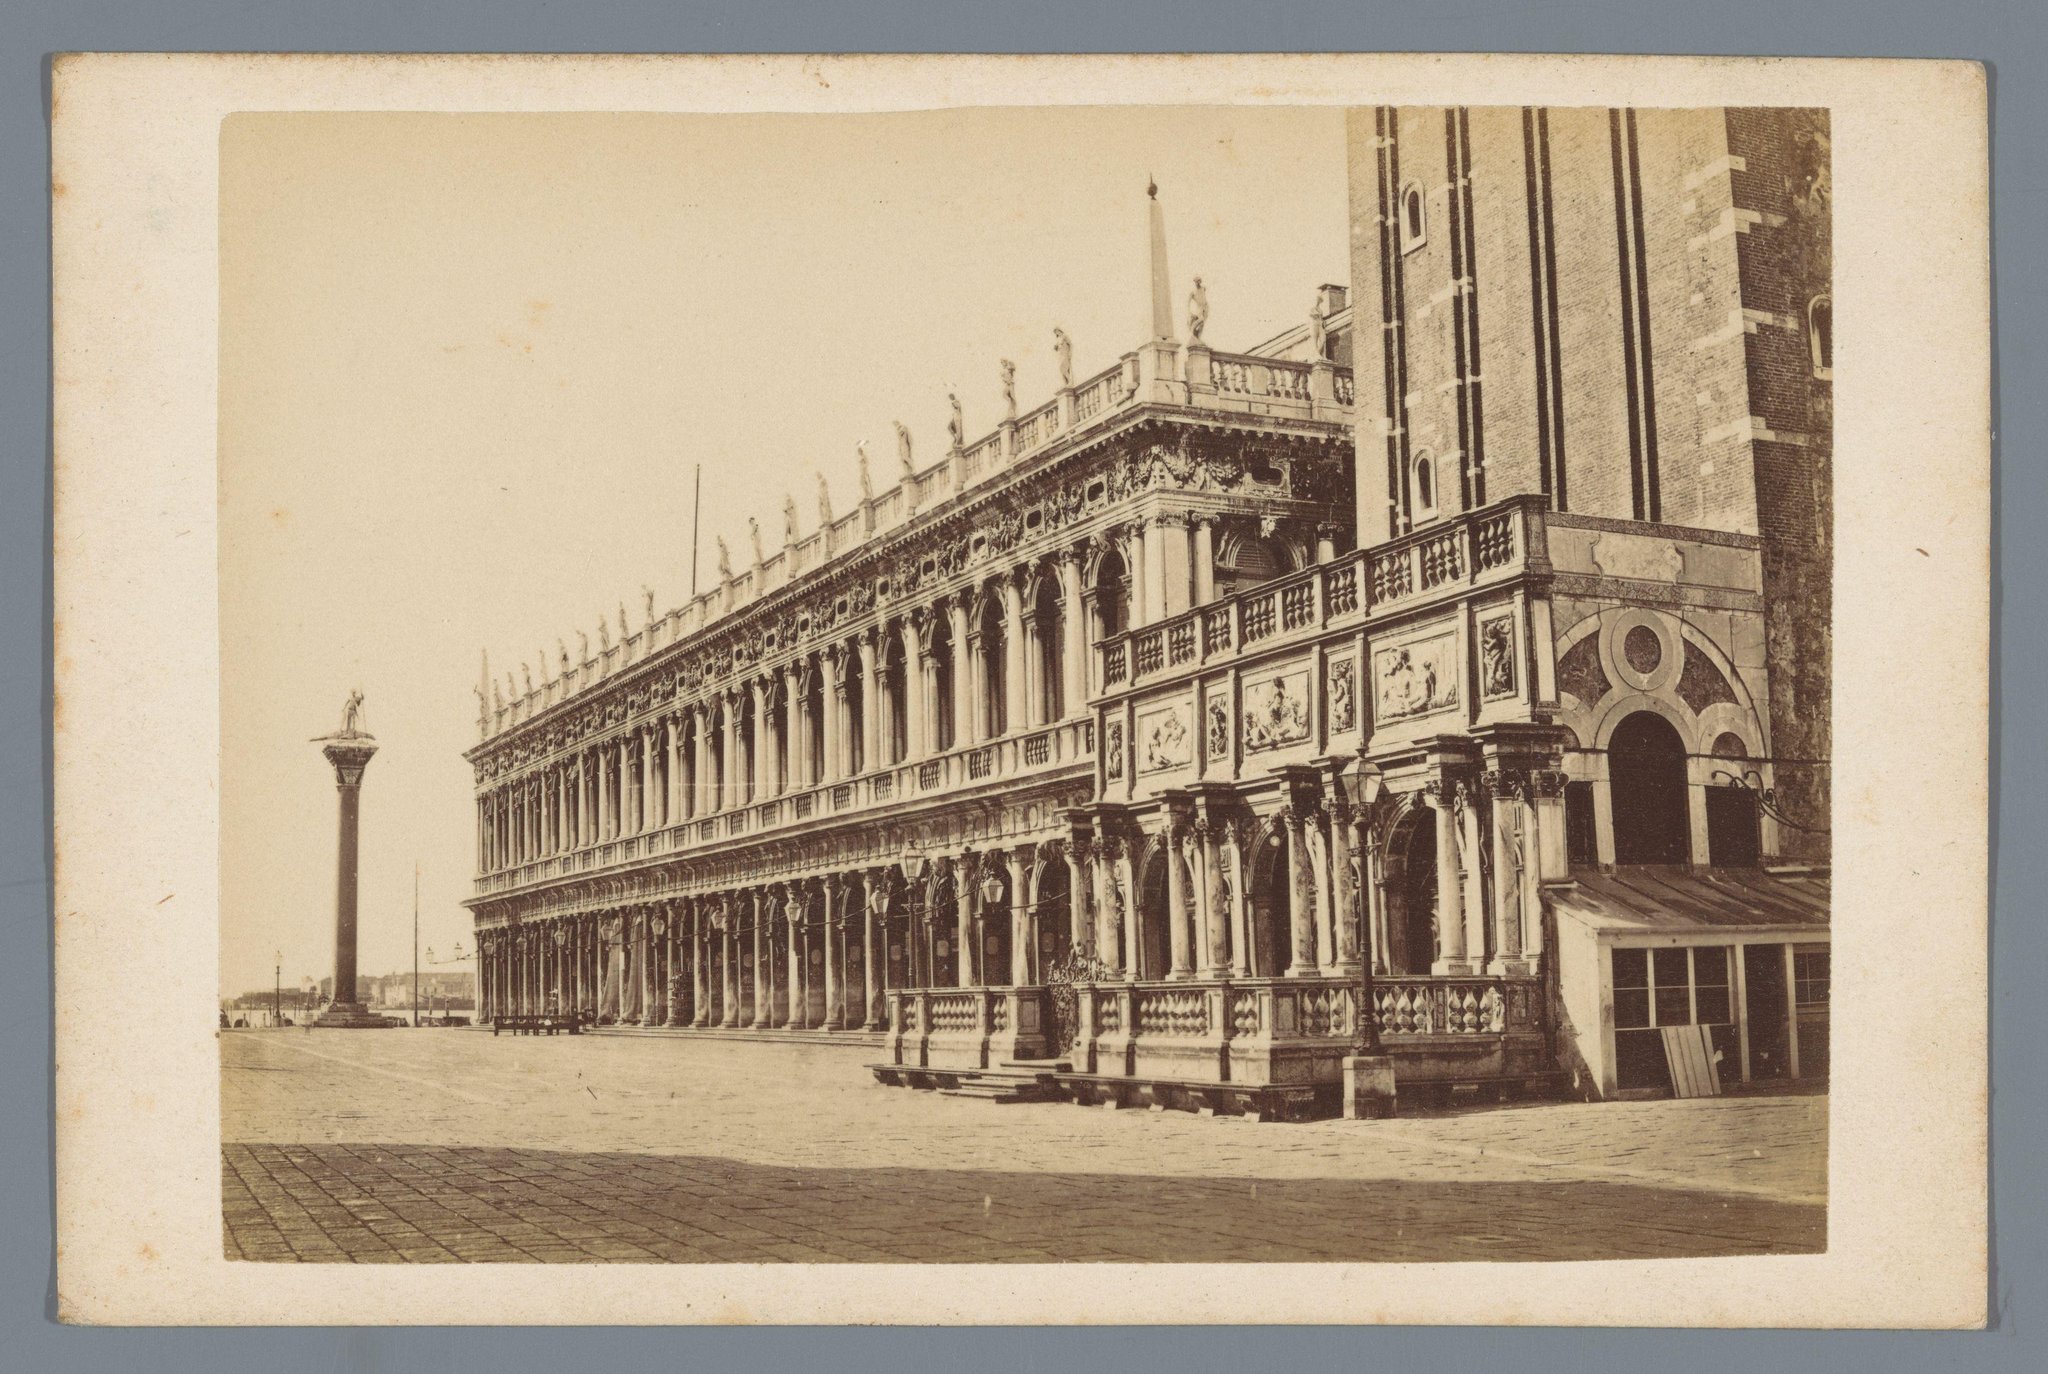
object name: cabinet photograph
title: Gezicht op La Logetta aan het San Marcoplein in Venetië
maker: Anonymous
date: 1850-1900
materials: cardboard, photographic support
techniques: albumen print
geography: san marco square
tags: civic architecture; edifices; dwellings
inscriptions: annotation: ‘Venezia la loggetta’